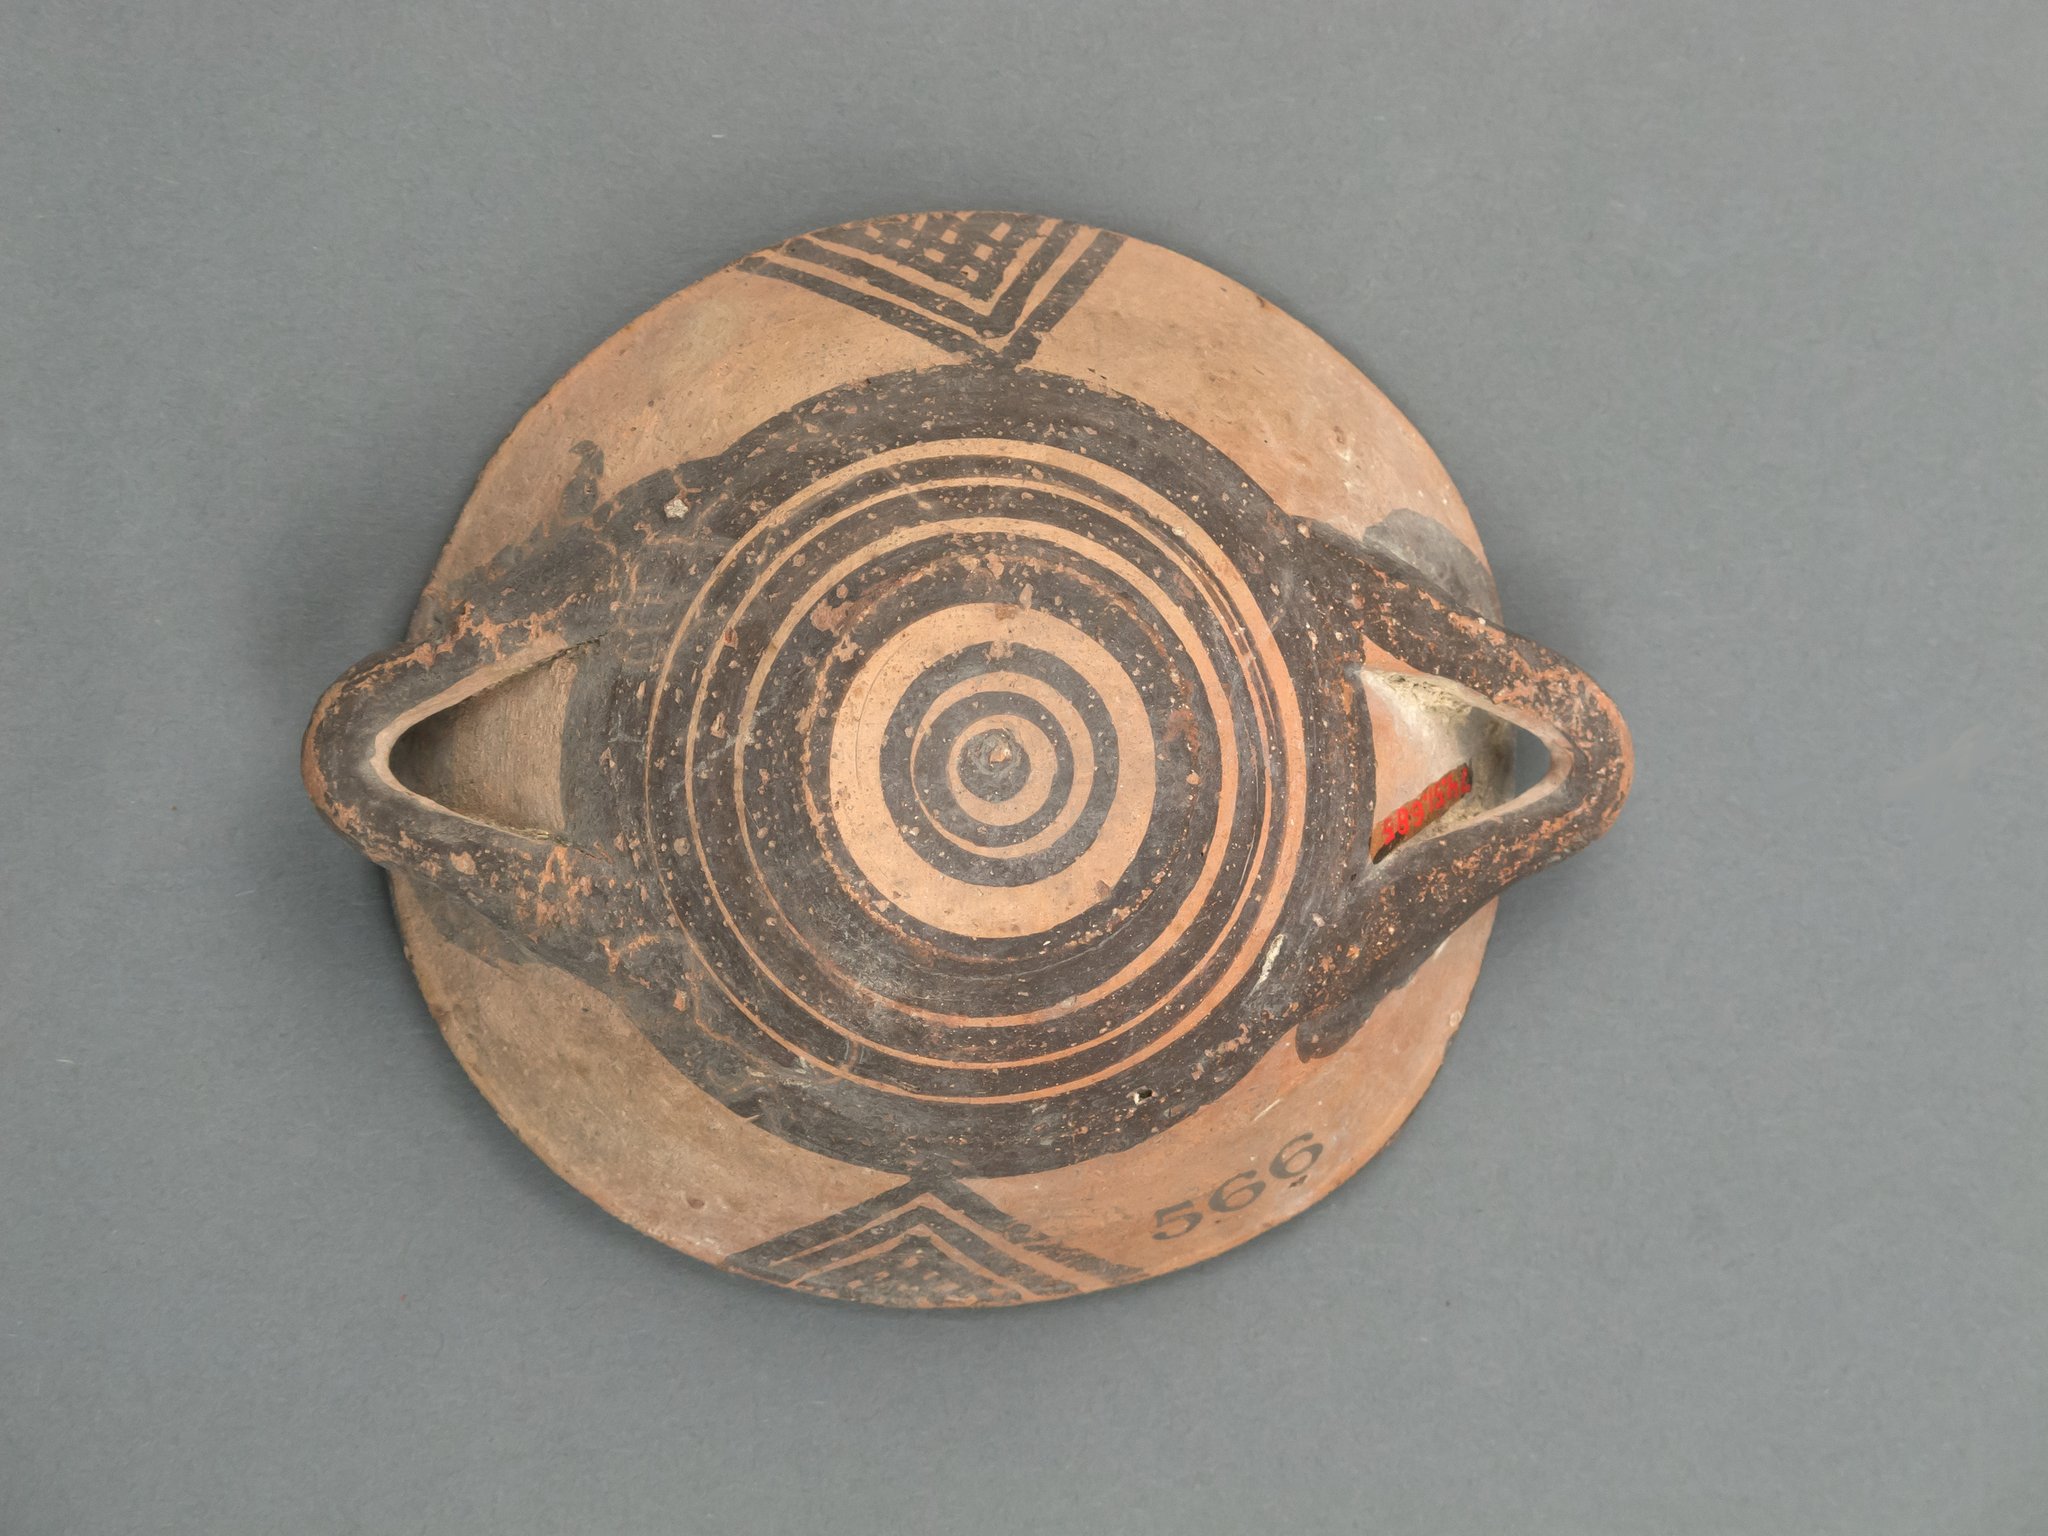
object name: bowl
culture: cypriot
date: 1050-950 BCE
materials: terracotta